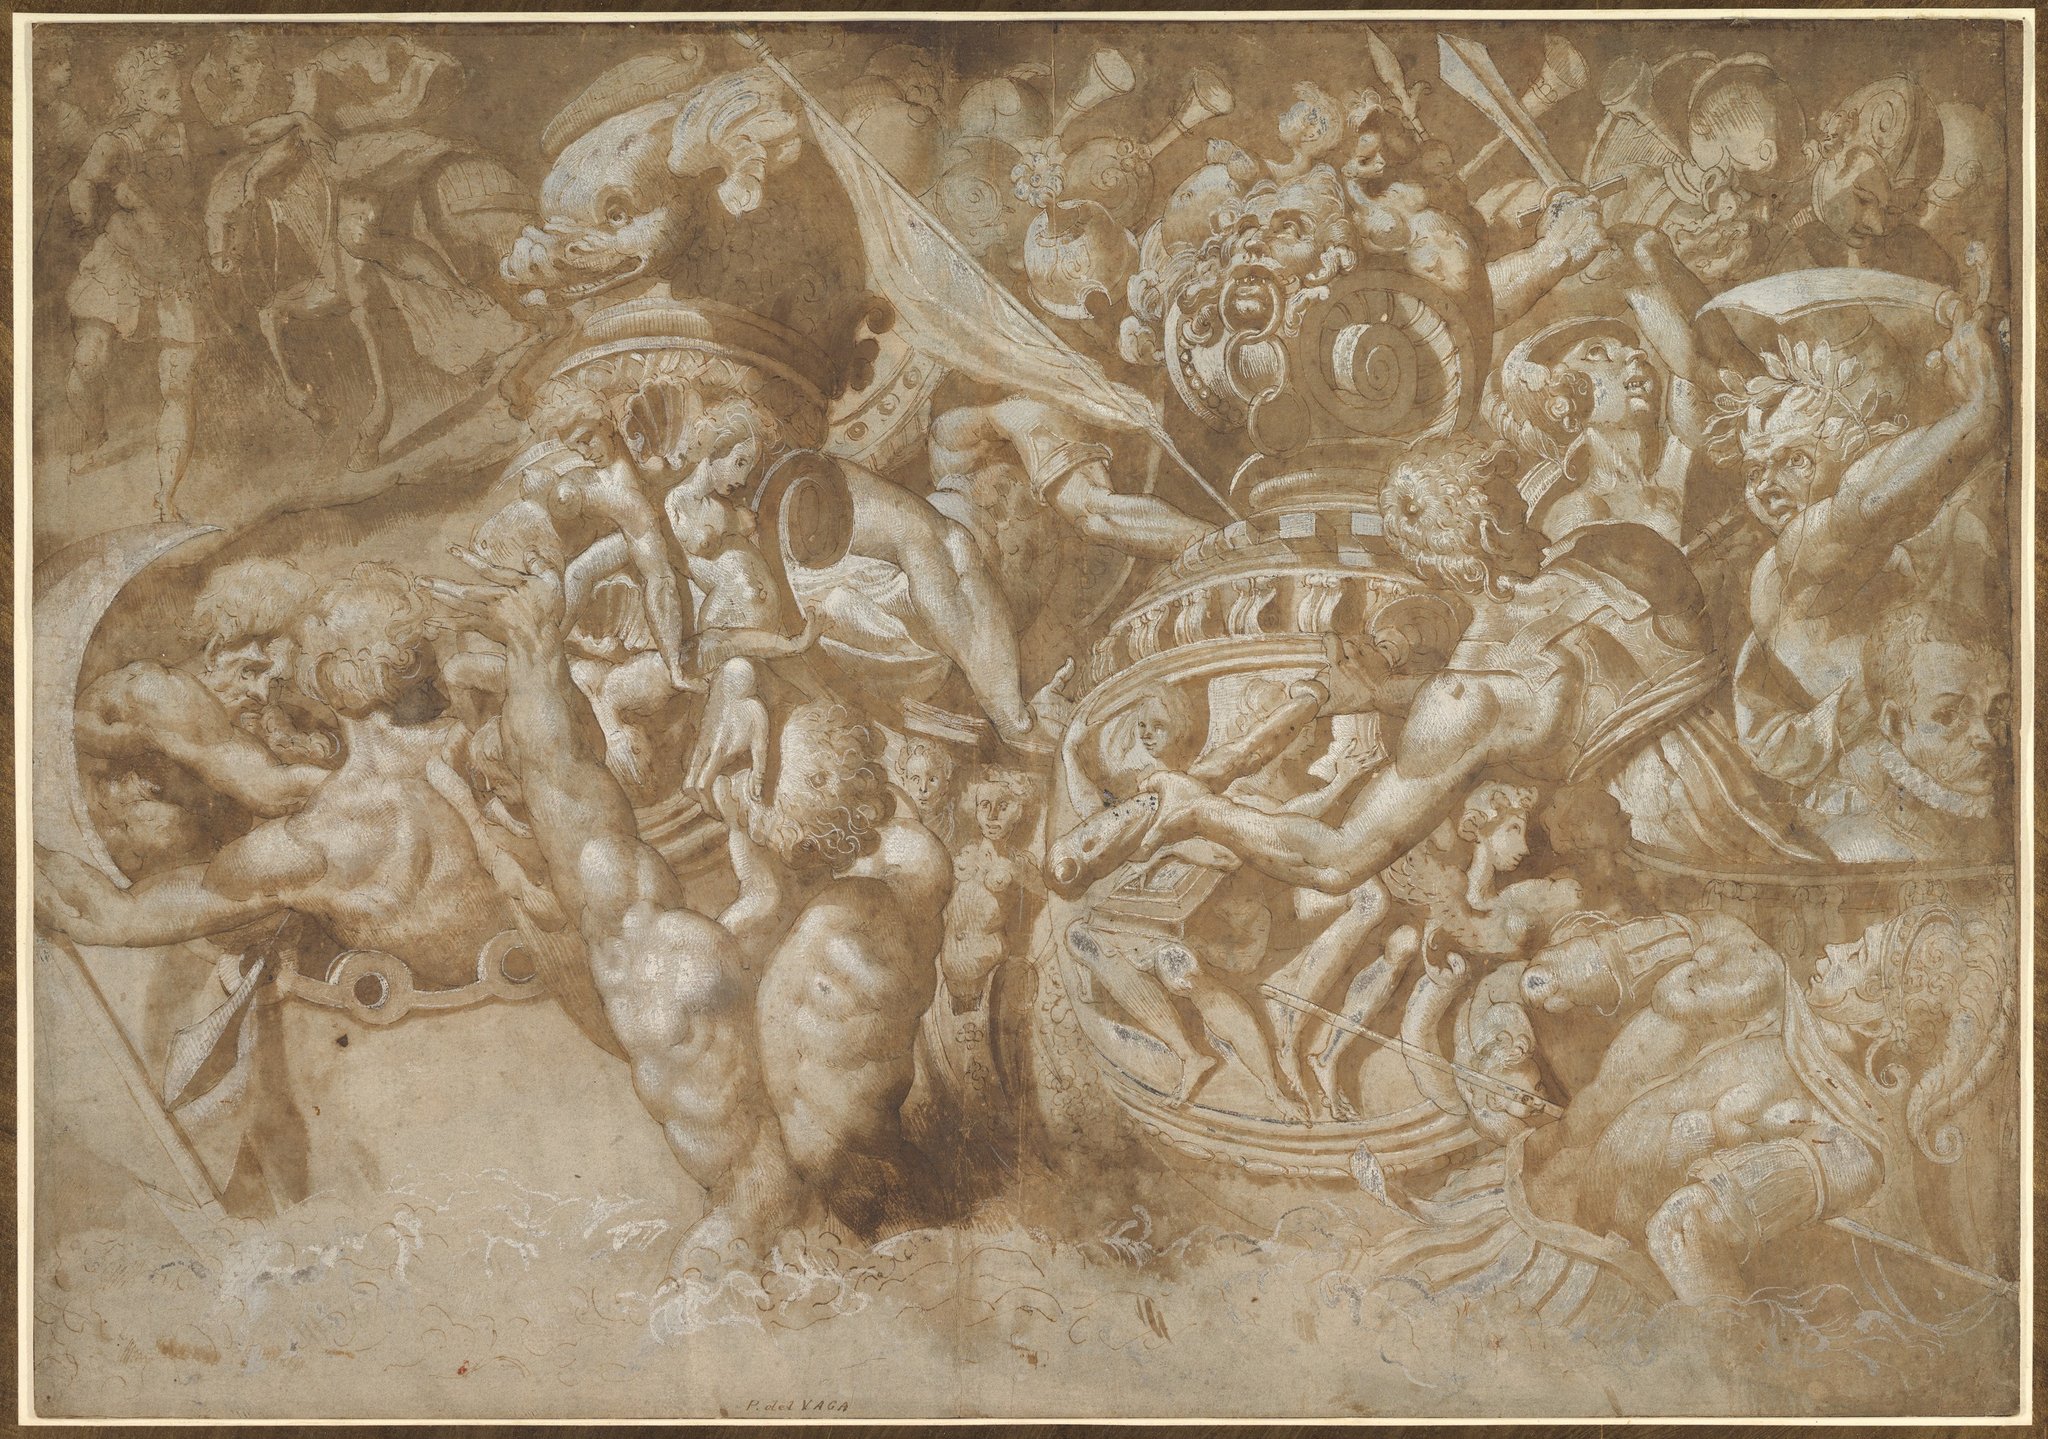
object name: drawing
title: Naval Battle Between Mythological Forces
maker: anonymous, italian, 19th century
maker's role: artist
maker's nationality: italian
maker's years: 1800-1900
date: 1801-1900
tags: battles,soldiers,weapons,men